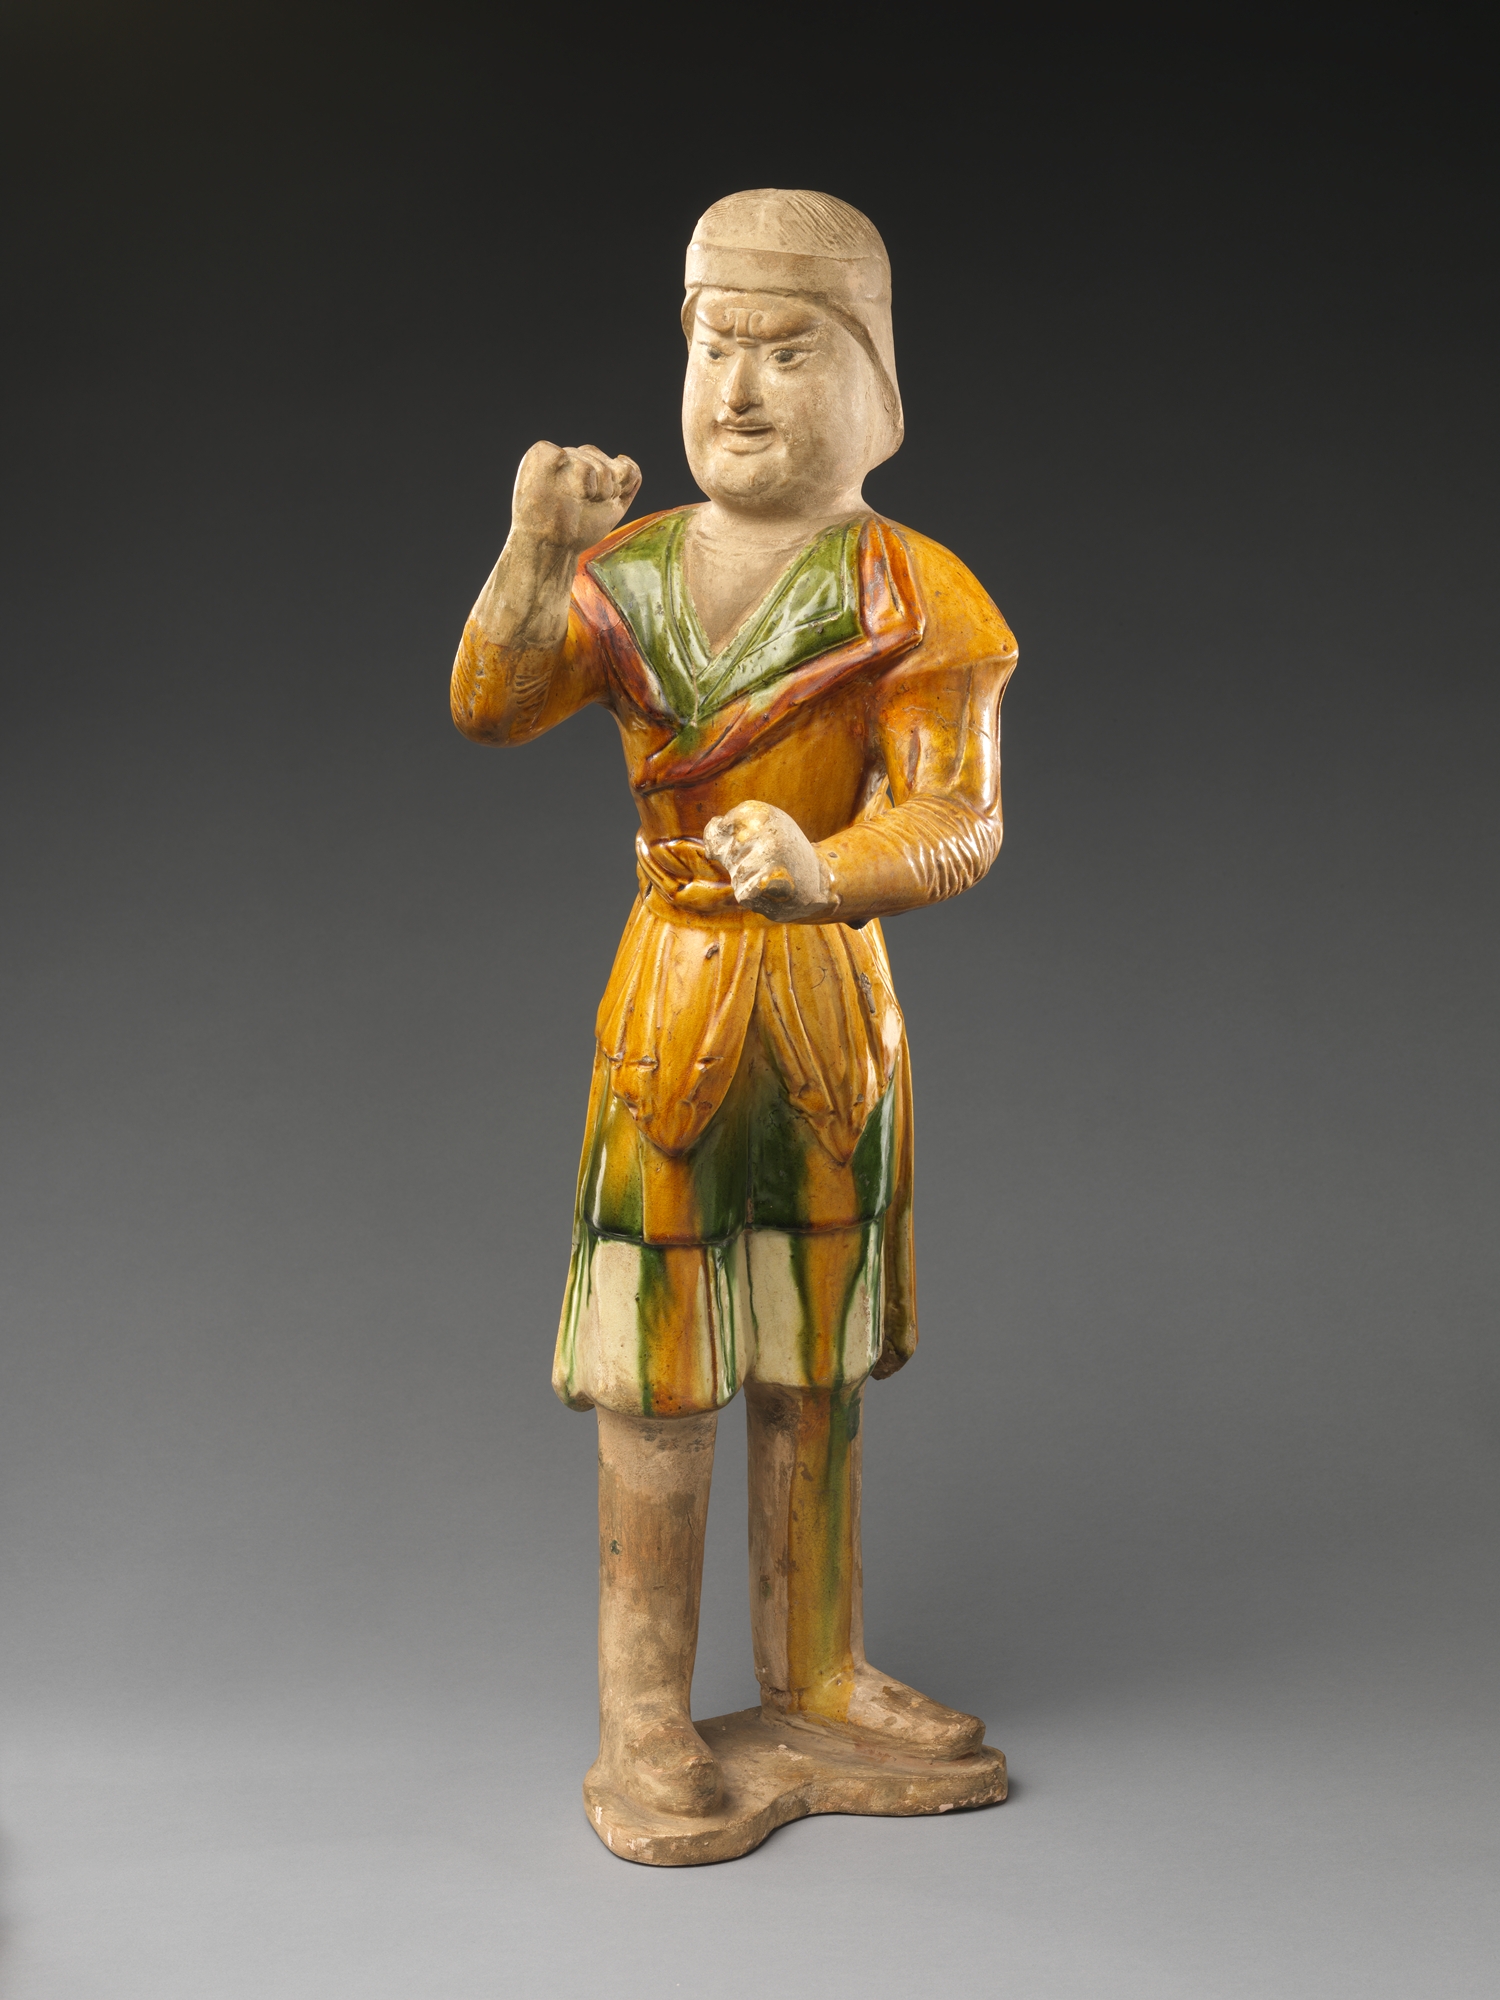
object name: figure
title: Horse groom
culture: chinese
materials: earthenware, glaze, pigment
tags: men